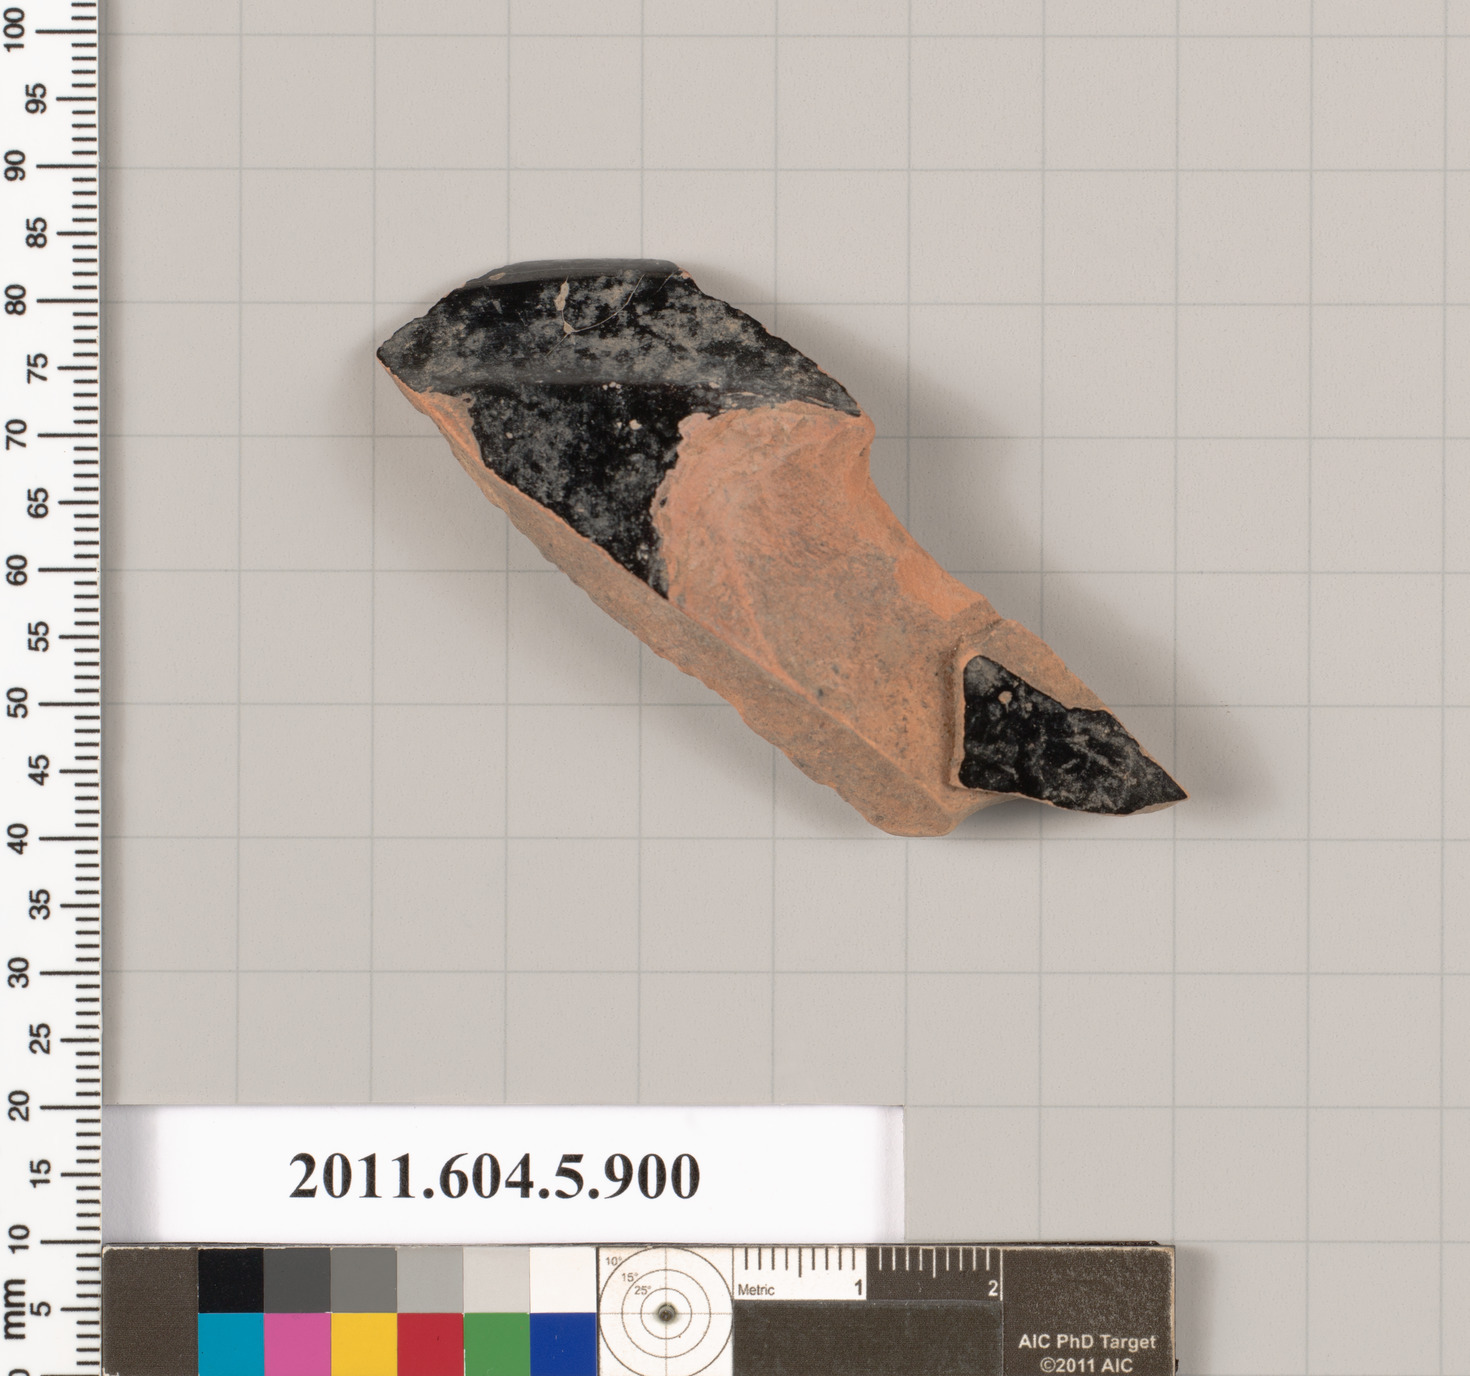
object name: kylix fragment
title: Terracotta fragment of a kylix (drinking cup)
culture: greek, attic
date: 600-401 BCE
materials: terracotta